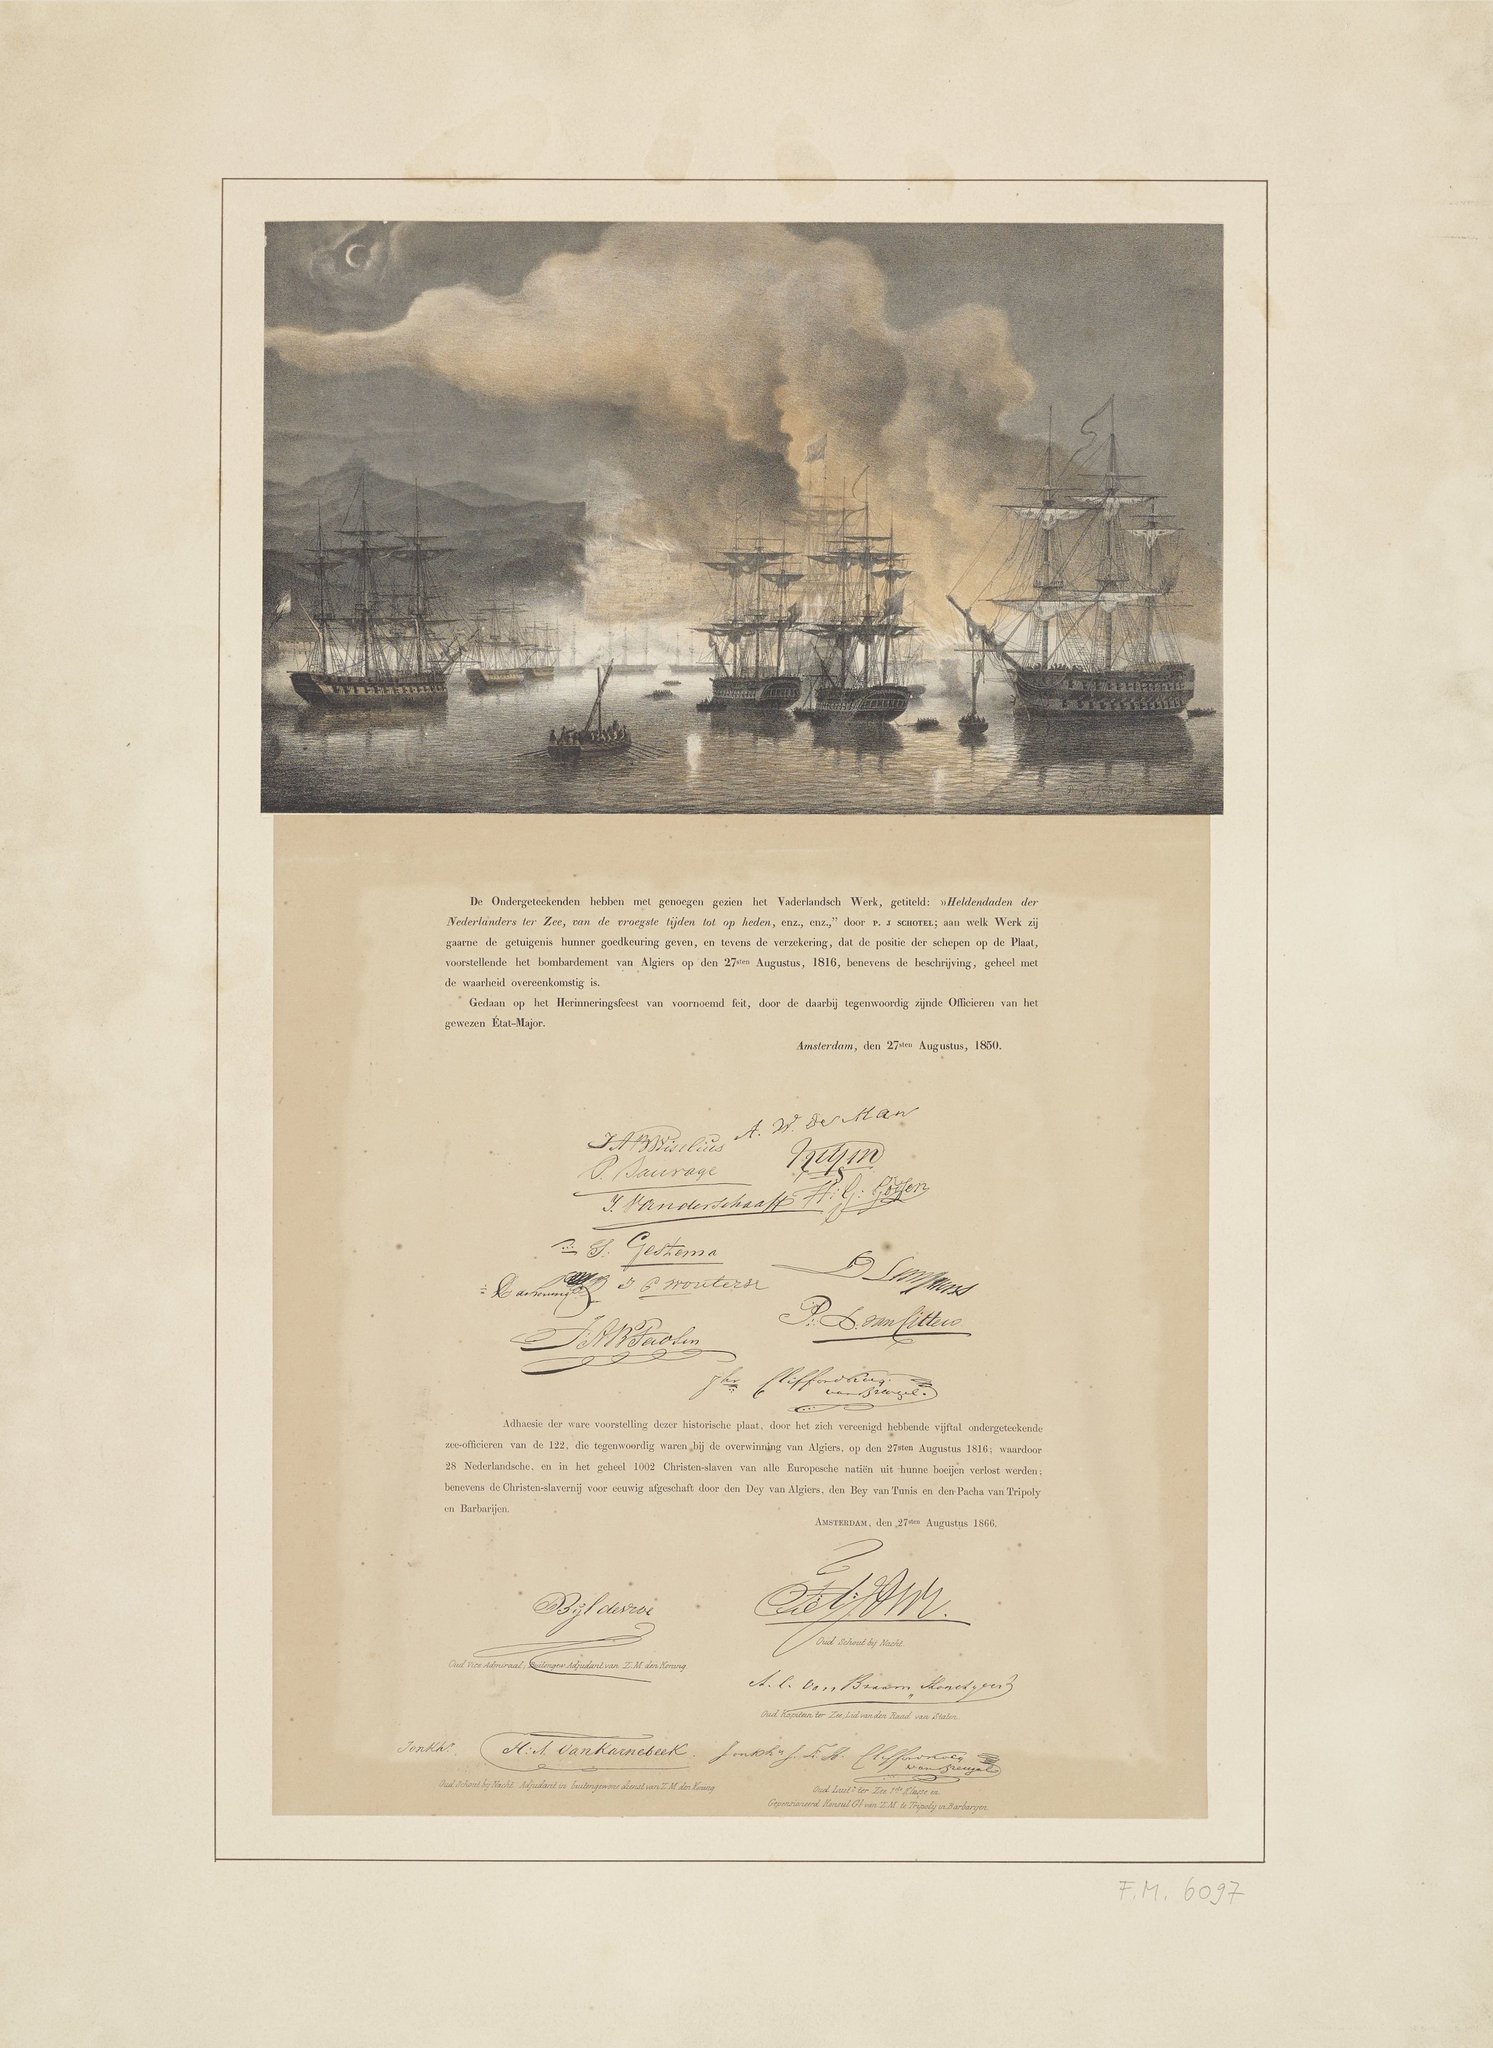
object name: history print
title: Bombardement van Algiers, 1816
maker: petrus johannes schotel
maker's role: draughtsman, painter, print maker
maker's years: 1808-1865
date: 1866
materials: paper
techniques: lithograph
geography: netherlands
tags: nijmegen, brussels, navy (+ sailing-ships), bombardment (+ sailing-ships), bombardment ~ siege (+ sailing-ships)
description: Het bombardement van de stad Algiers door een verenigd Brits en Nederlands eskader onder commando van Lord Exmouth en Baron van der Capelle, in de nacht van 26 op 27 augustus 1816. Onder de plaat een blad met de namen en handtekeningen van een groep personen die verklaren dat de voorstelling van het bombardement met de waarheid overeenkomstig is, gedaan op het Herinneringsfeest te Amsterdam op 27 augustus 1850. Daaronder op hetzelfde blad de namen en handtekeningen van een vijftal zeeofficieren die aanwezig waren bij het bombardement en de daaropvolgende bevrijding van 1002 gevangen genomen zeelieden en vissers, waaronder 28 Nederlanders, uit Algiers. Deze tweede groep namen bij de vijftigjarige herdenking van het bombardement op 27 augustus 1866 te Amsterdam. Prent en tekst samen op een groter blad geplakt.